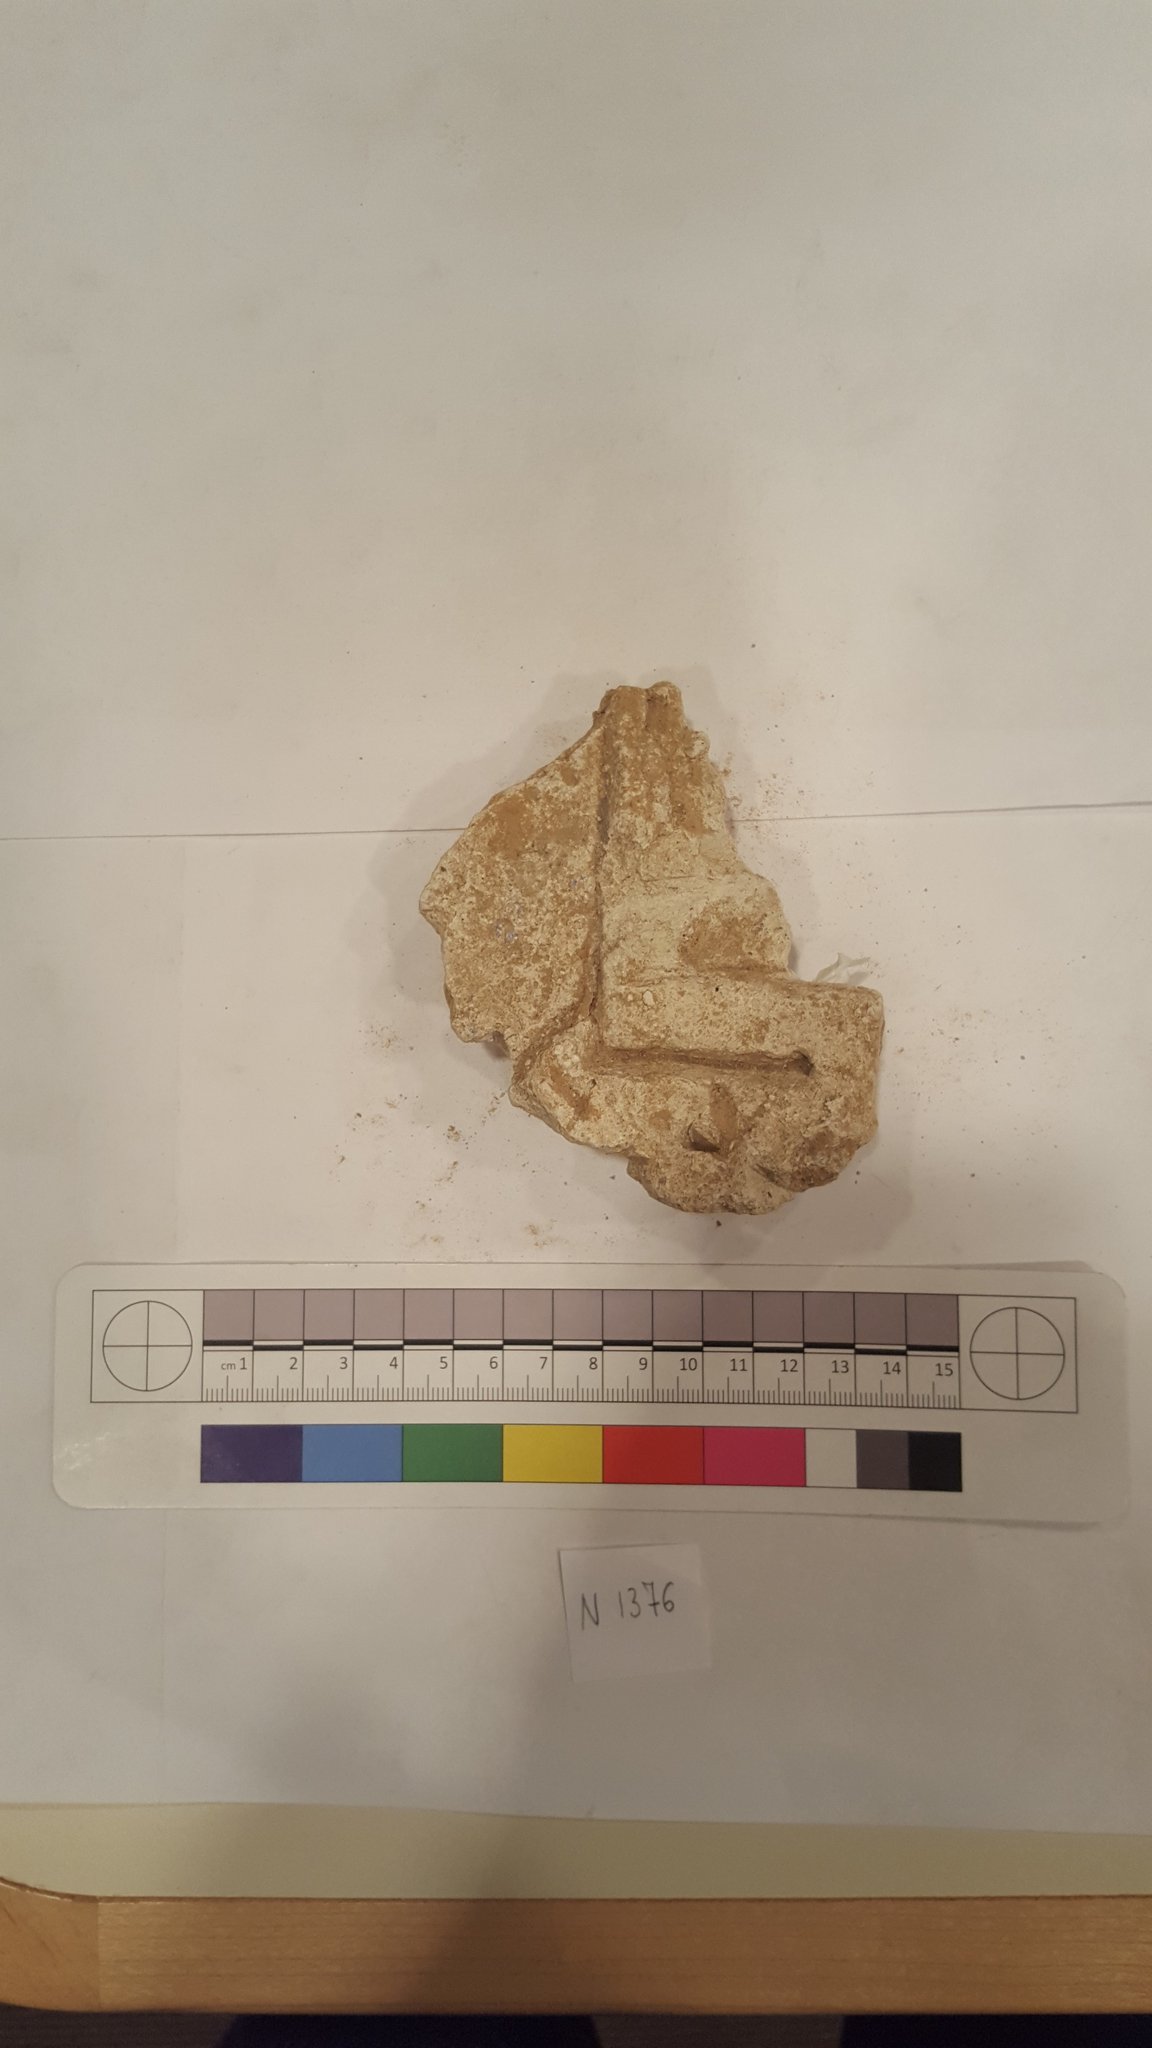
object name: fragment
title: Stucco Fragment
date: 701-1200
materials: plaster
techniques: carving, painting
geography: iran